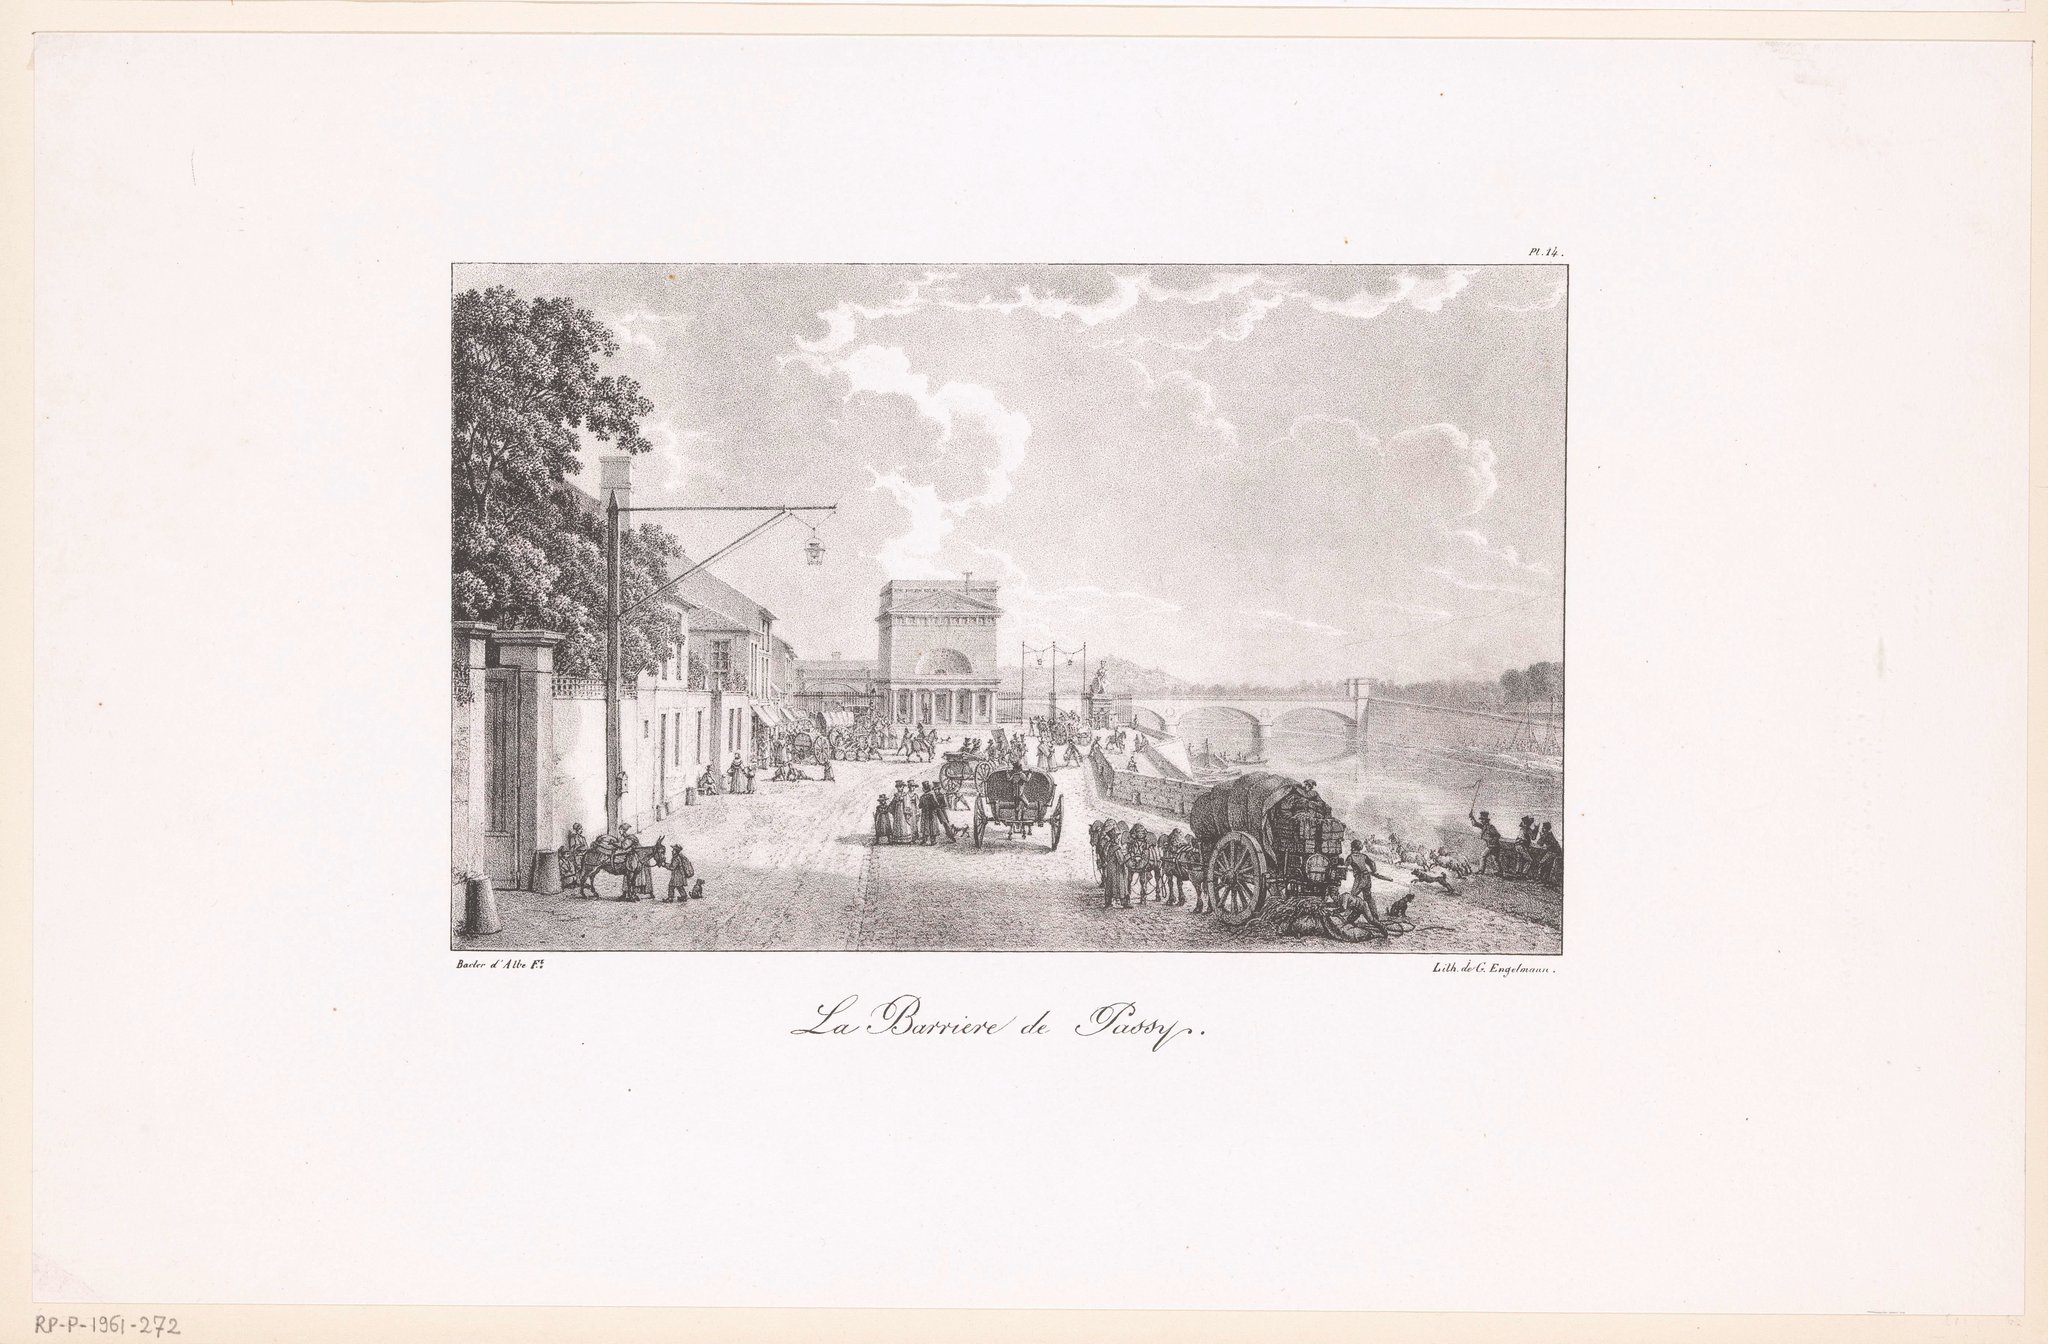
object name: print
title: Zicht op de barrière van Passy in Parijs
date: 1822-1824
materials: paper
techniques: lithograph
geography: paris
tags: bridge in city across river, canal, etc. (+ city(-scape) with figures, staffage), toll gate, (farm) wagon, freight wagon, cart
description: De Barrière de Passy was een van de 55 doorgangen in de Muur van de Belastingpachters in Parijs. Bij het accijnshuis naast de tolpoort werd belasting geïnd op goederen die de stad in- en uitgingen.